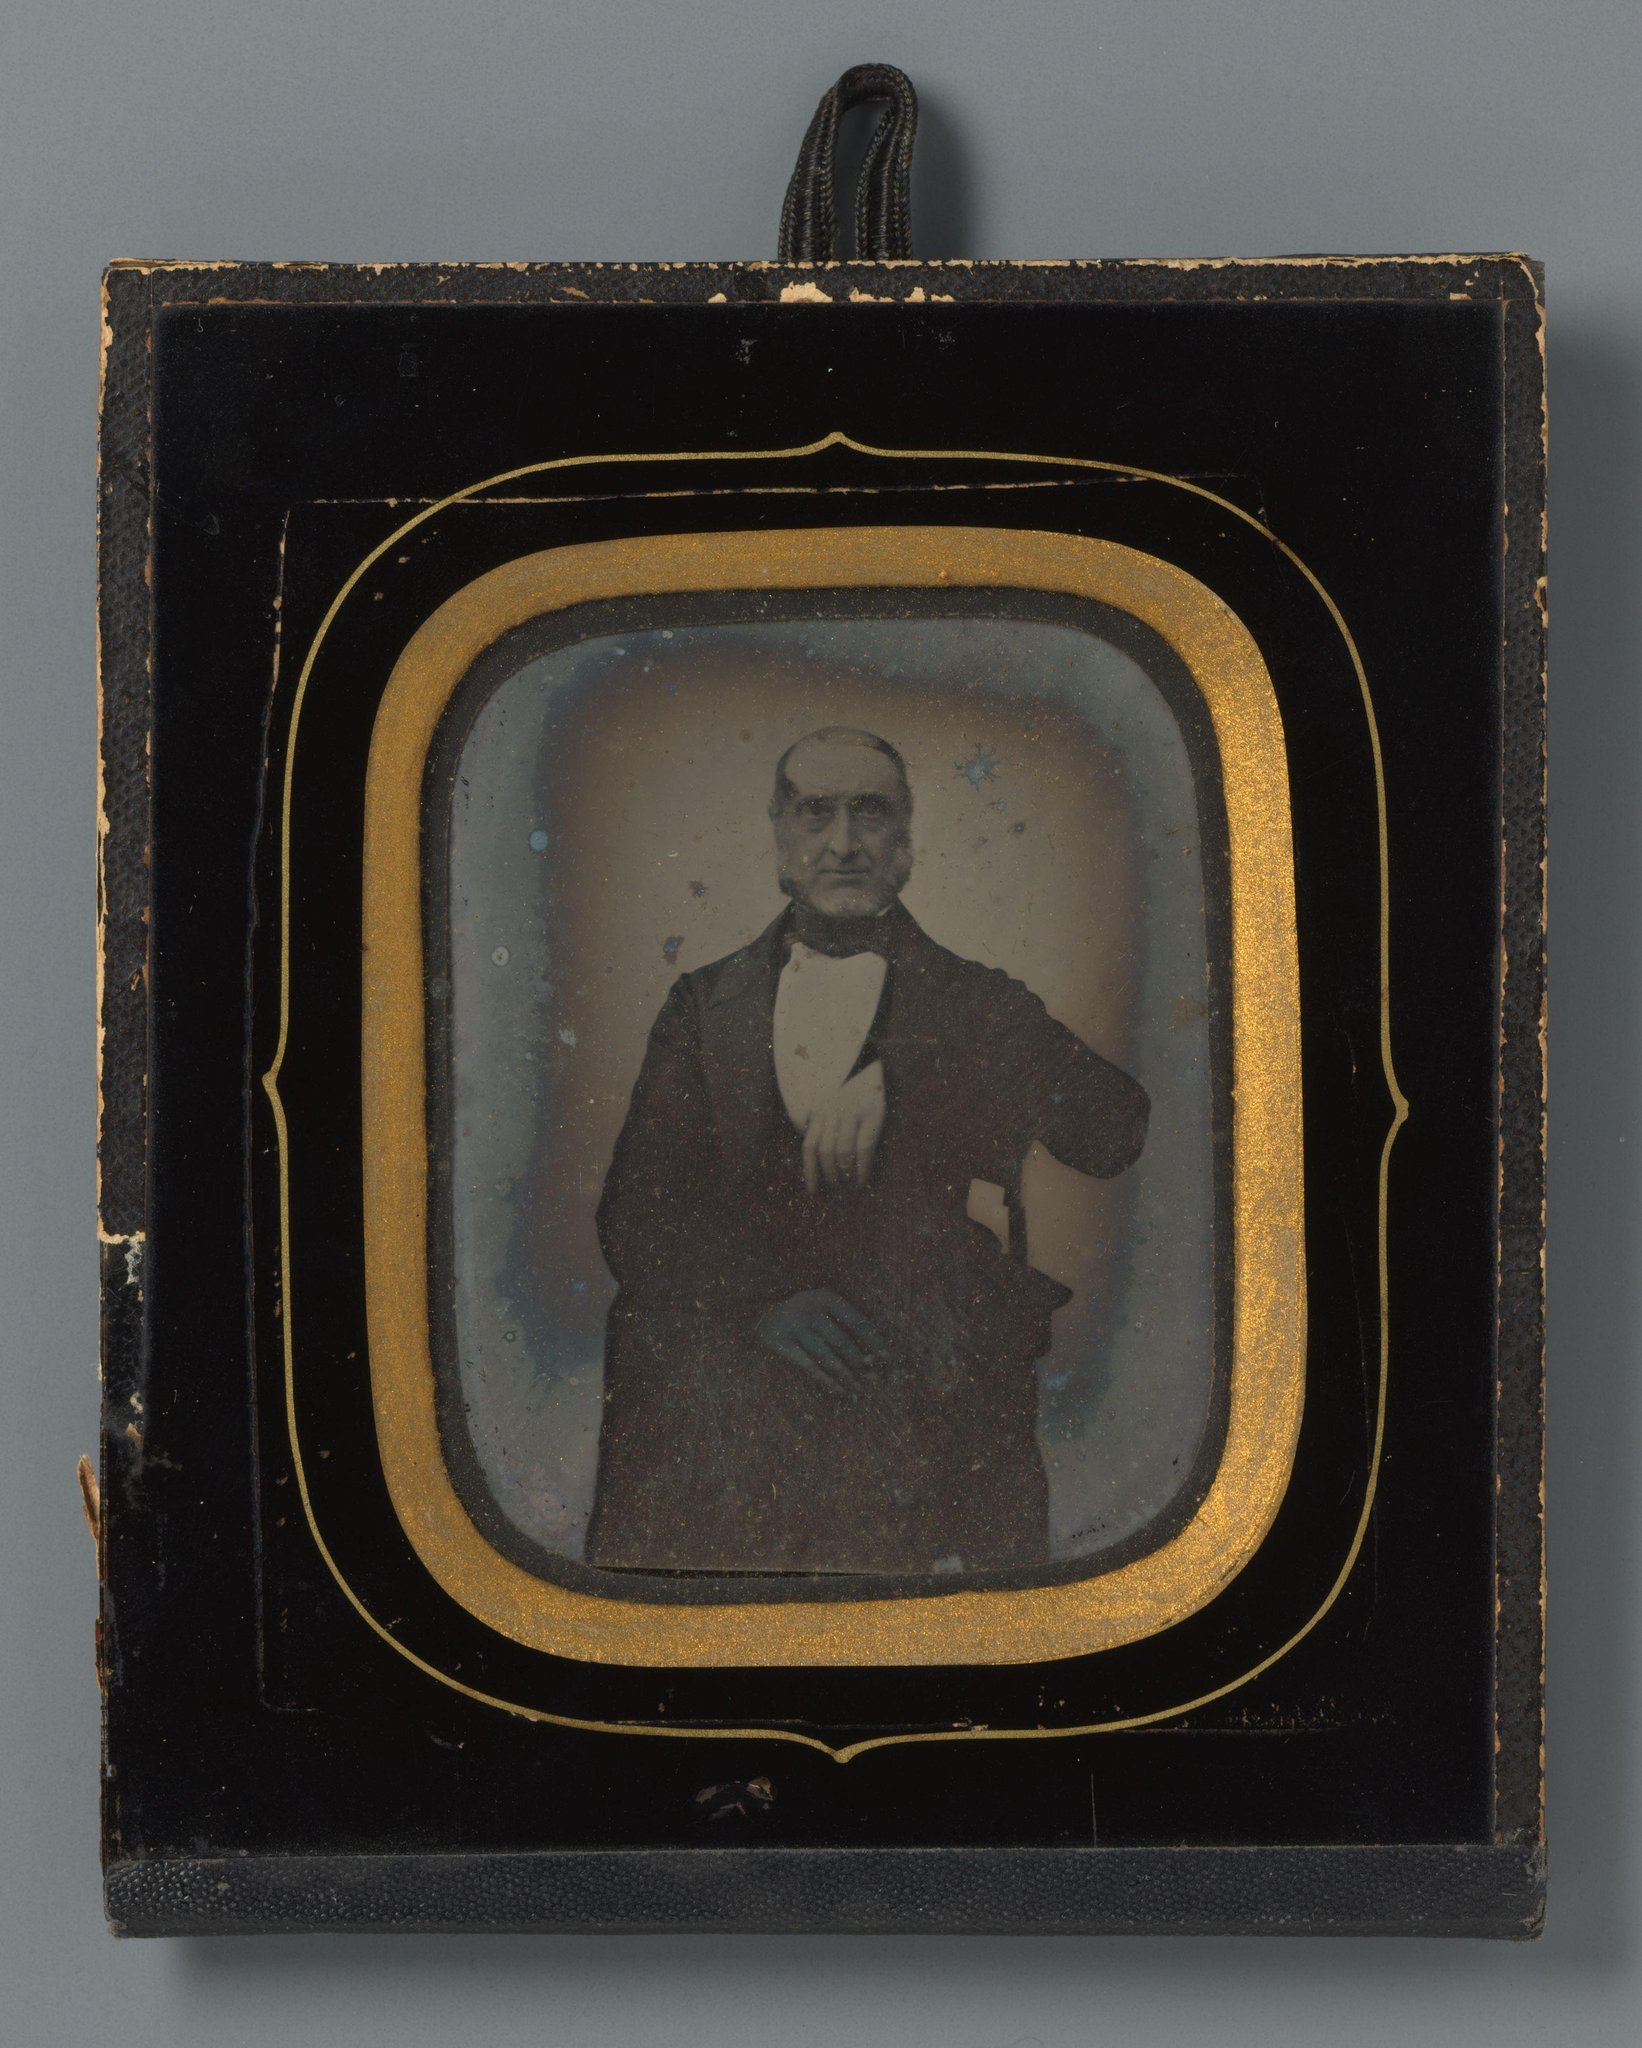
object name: photograph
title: Portret van Wouter Holleman, fabrikant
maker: Anonymous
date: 1855-1870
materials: cardboard, glass, paper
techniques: ambrotype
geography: netherlands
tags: historical persons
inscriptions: inscription: ‘Wouter (...) 1831.’